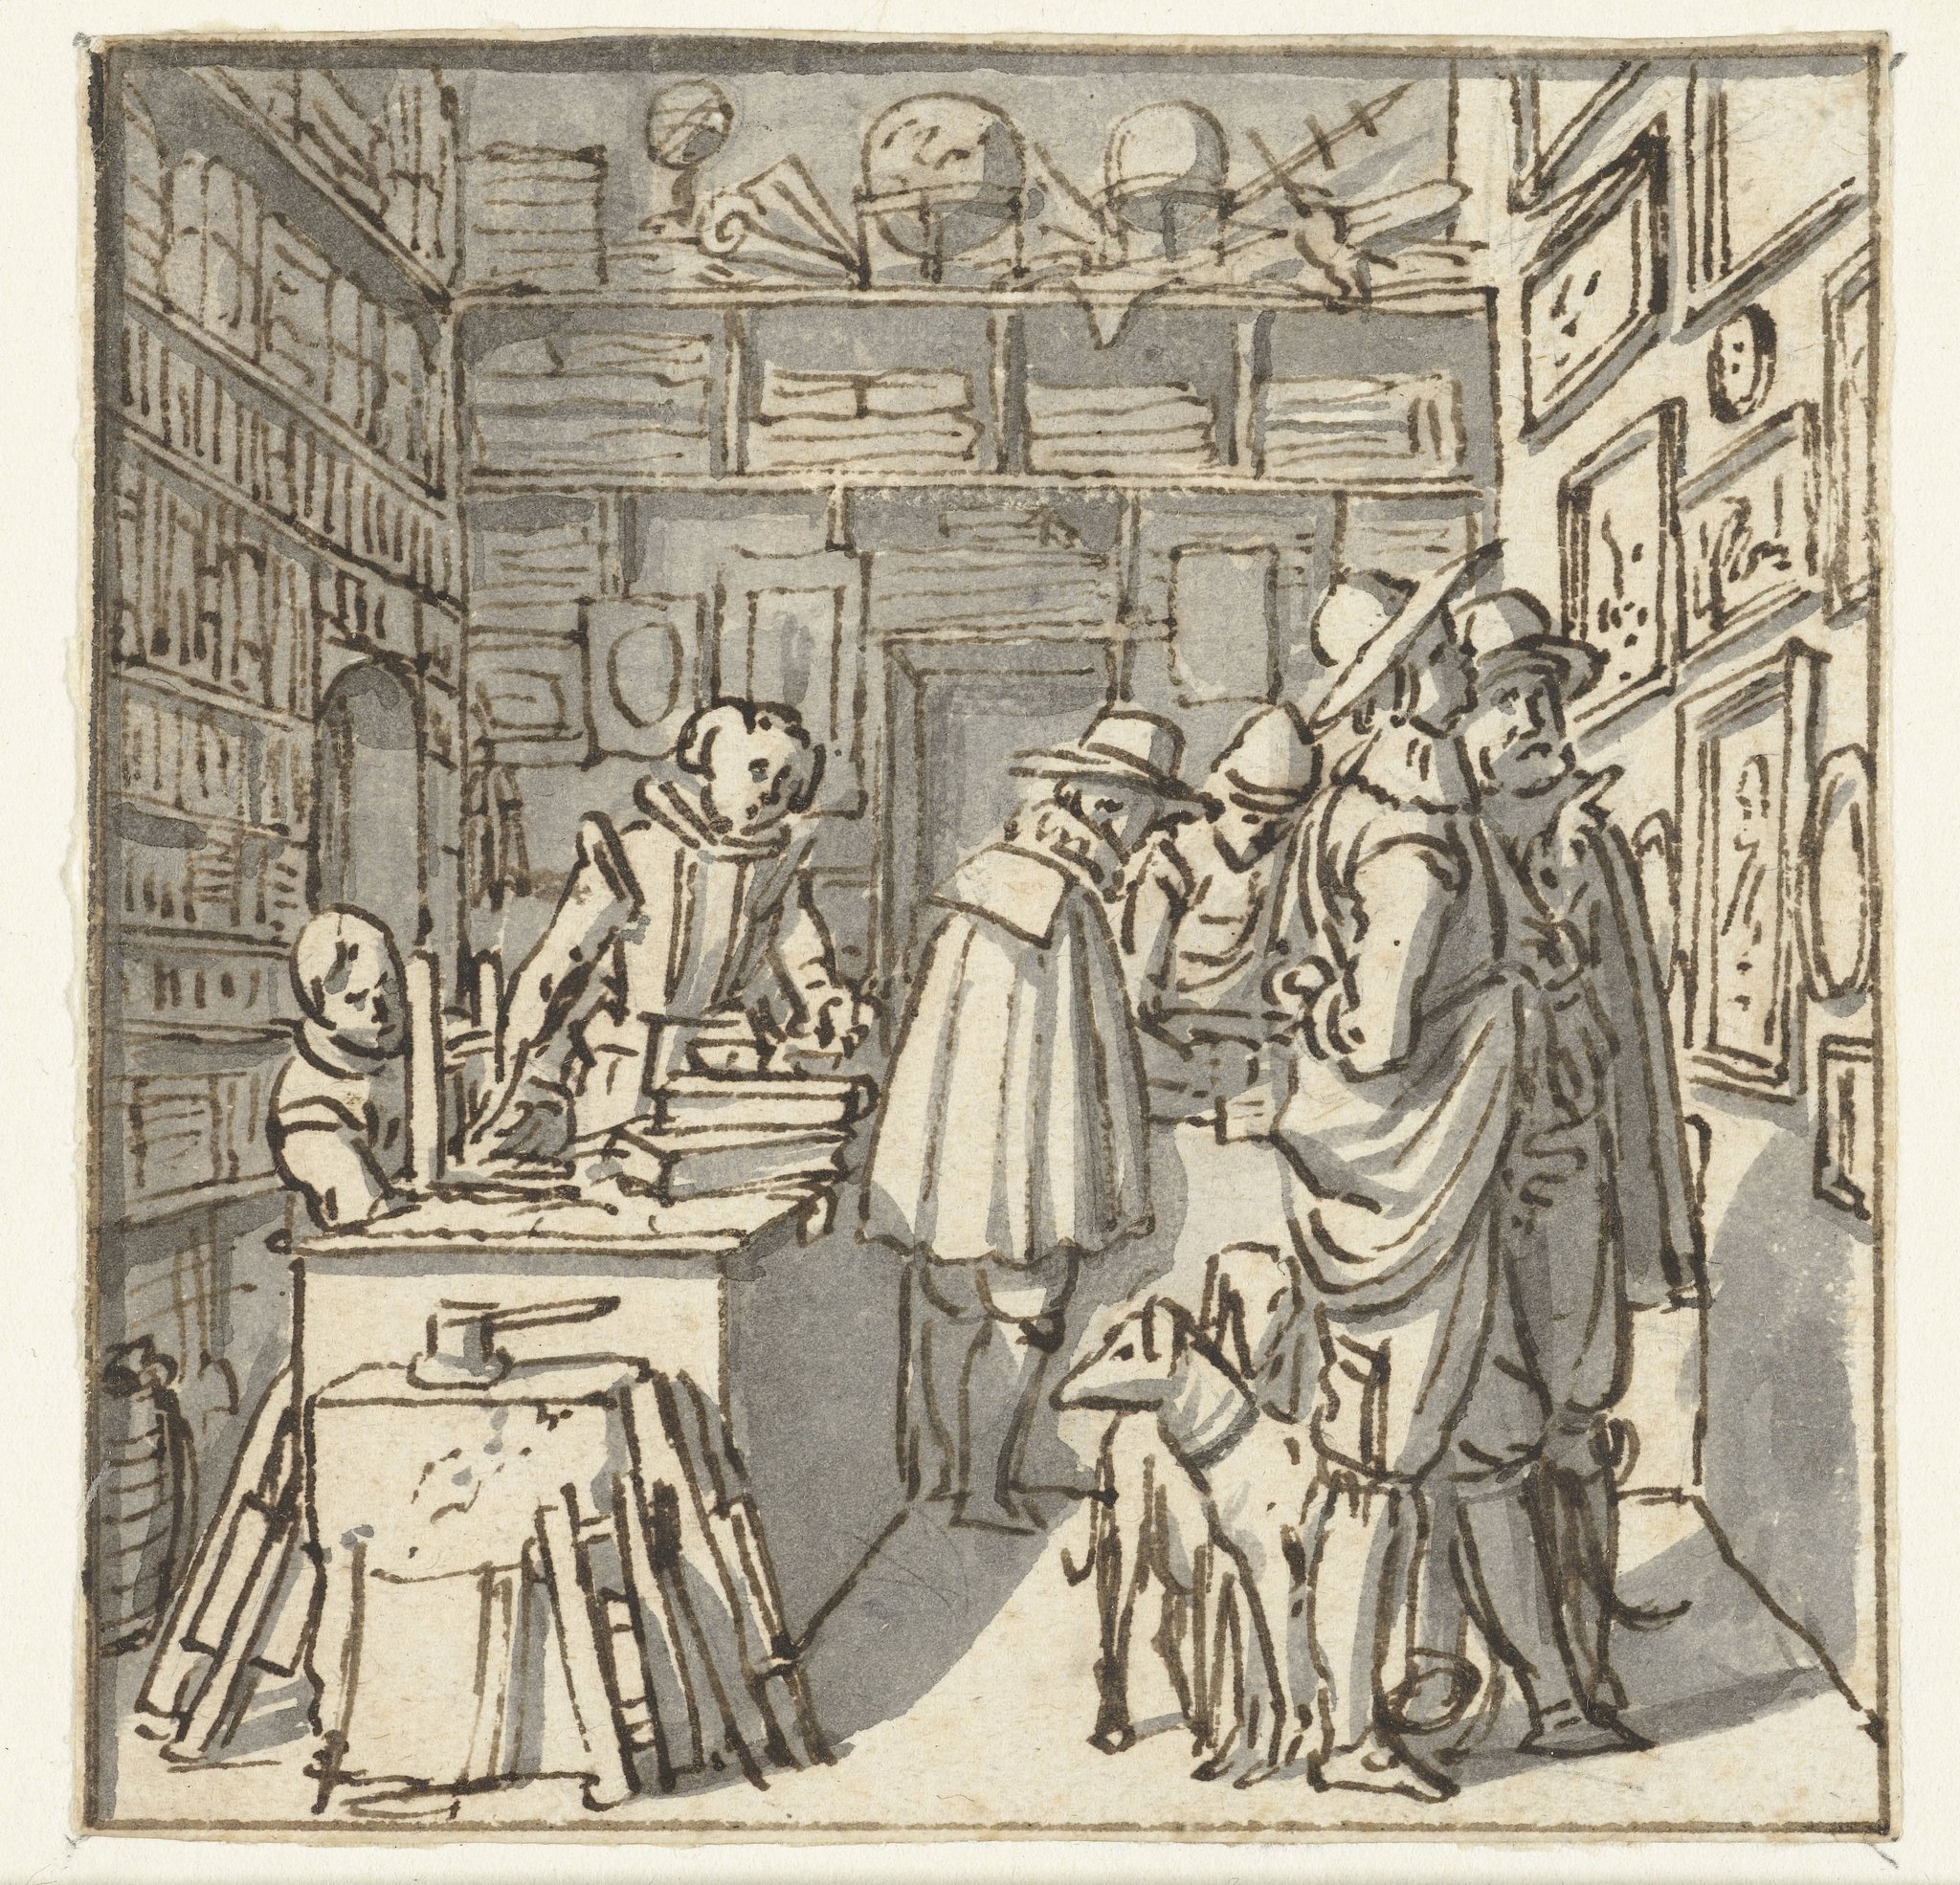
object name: drawing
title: Interior of a Bookshop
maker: salomon de bray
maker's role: draughtsman, print maker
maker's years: 1597-1664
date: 1628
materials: ink, paper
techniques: brush, pen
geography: haarlem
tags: drawing, sketch, book with clasps, counter ~ shop, adult woman, print, e.g.: engraving, etching, lithograph, adult man, book, art dealer, picture, painting, globe, dog, book-shop, bookseller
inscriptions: collector's mark: Lugt 2228, inscription: ‘No. 3634.’, collector's mark: Lugt 2135, inscription: ‘S. de Braij 1628’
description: Interieur van een vermoedelijk Haarlemse boek- en kunsthandel. Achter de toonbank links de winkelierster met naast haar een jongen die achter een naairaam een boek aan het naaien is. Achter hen stellingen met op de twee bovenste planken voorraden ongebonden papier. Eronder staan gebonden of gebrocheerde boeken, terwijl op de vierde plank van boven vermoedelijk gebonden boeken zijn geplaatst die met de snede en dus met de sloten naar ons toegekeerd zijn. Vooraan tegen de toonbank staan, van links naar rechts, een boek in een blokpers, een klopsteen met een klophamer erop en een lege blokpers. Achter de toonbank rechts de winkelier met een klant. In de kast tegen de achterwand liggen pakken ongebonden boeken (in vellen) of blanco papier en op de bovenste plank staan onder andere globes. Rechts staan twee klanten met (wind?)honden te kijken naar de kunstwerken aan de wand, vermoedelijk schilderijen, prenten en/of tekeningen.